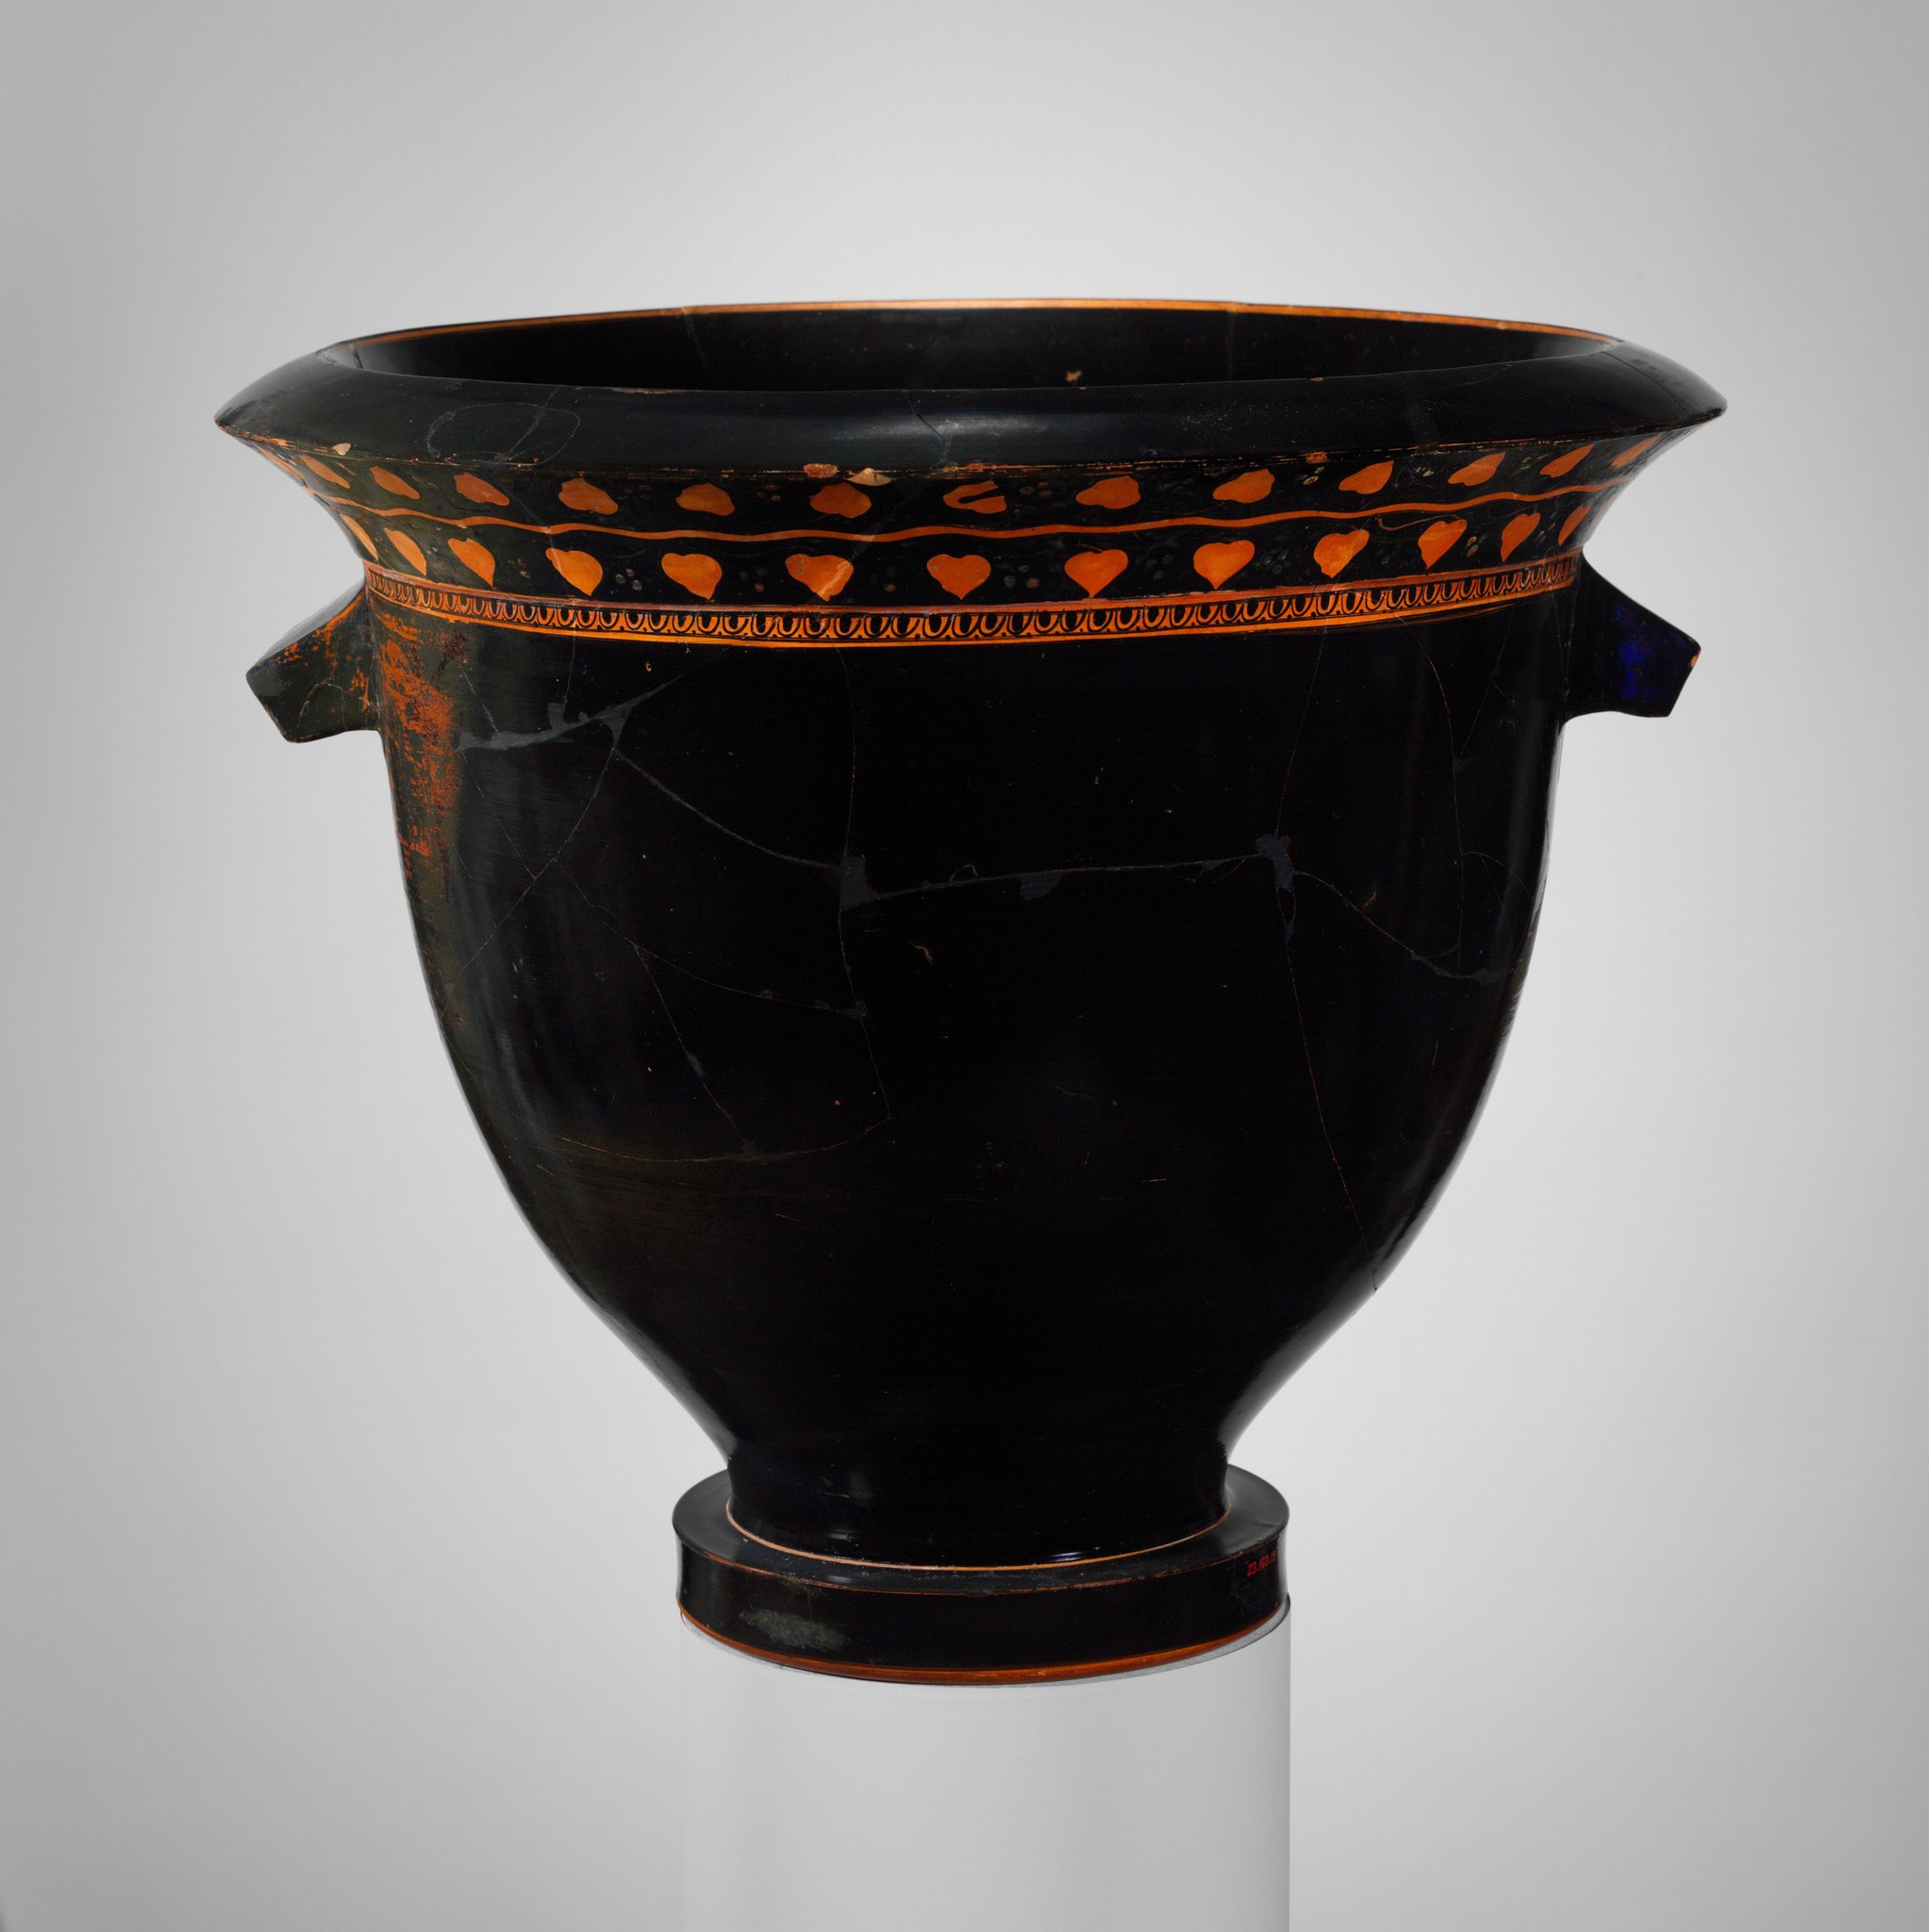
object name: bell krater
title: Terracotta bell-krater (bowl for mixing wine and water)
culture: greek, attic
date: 470-450 BCE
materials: terracotta